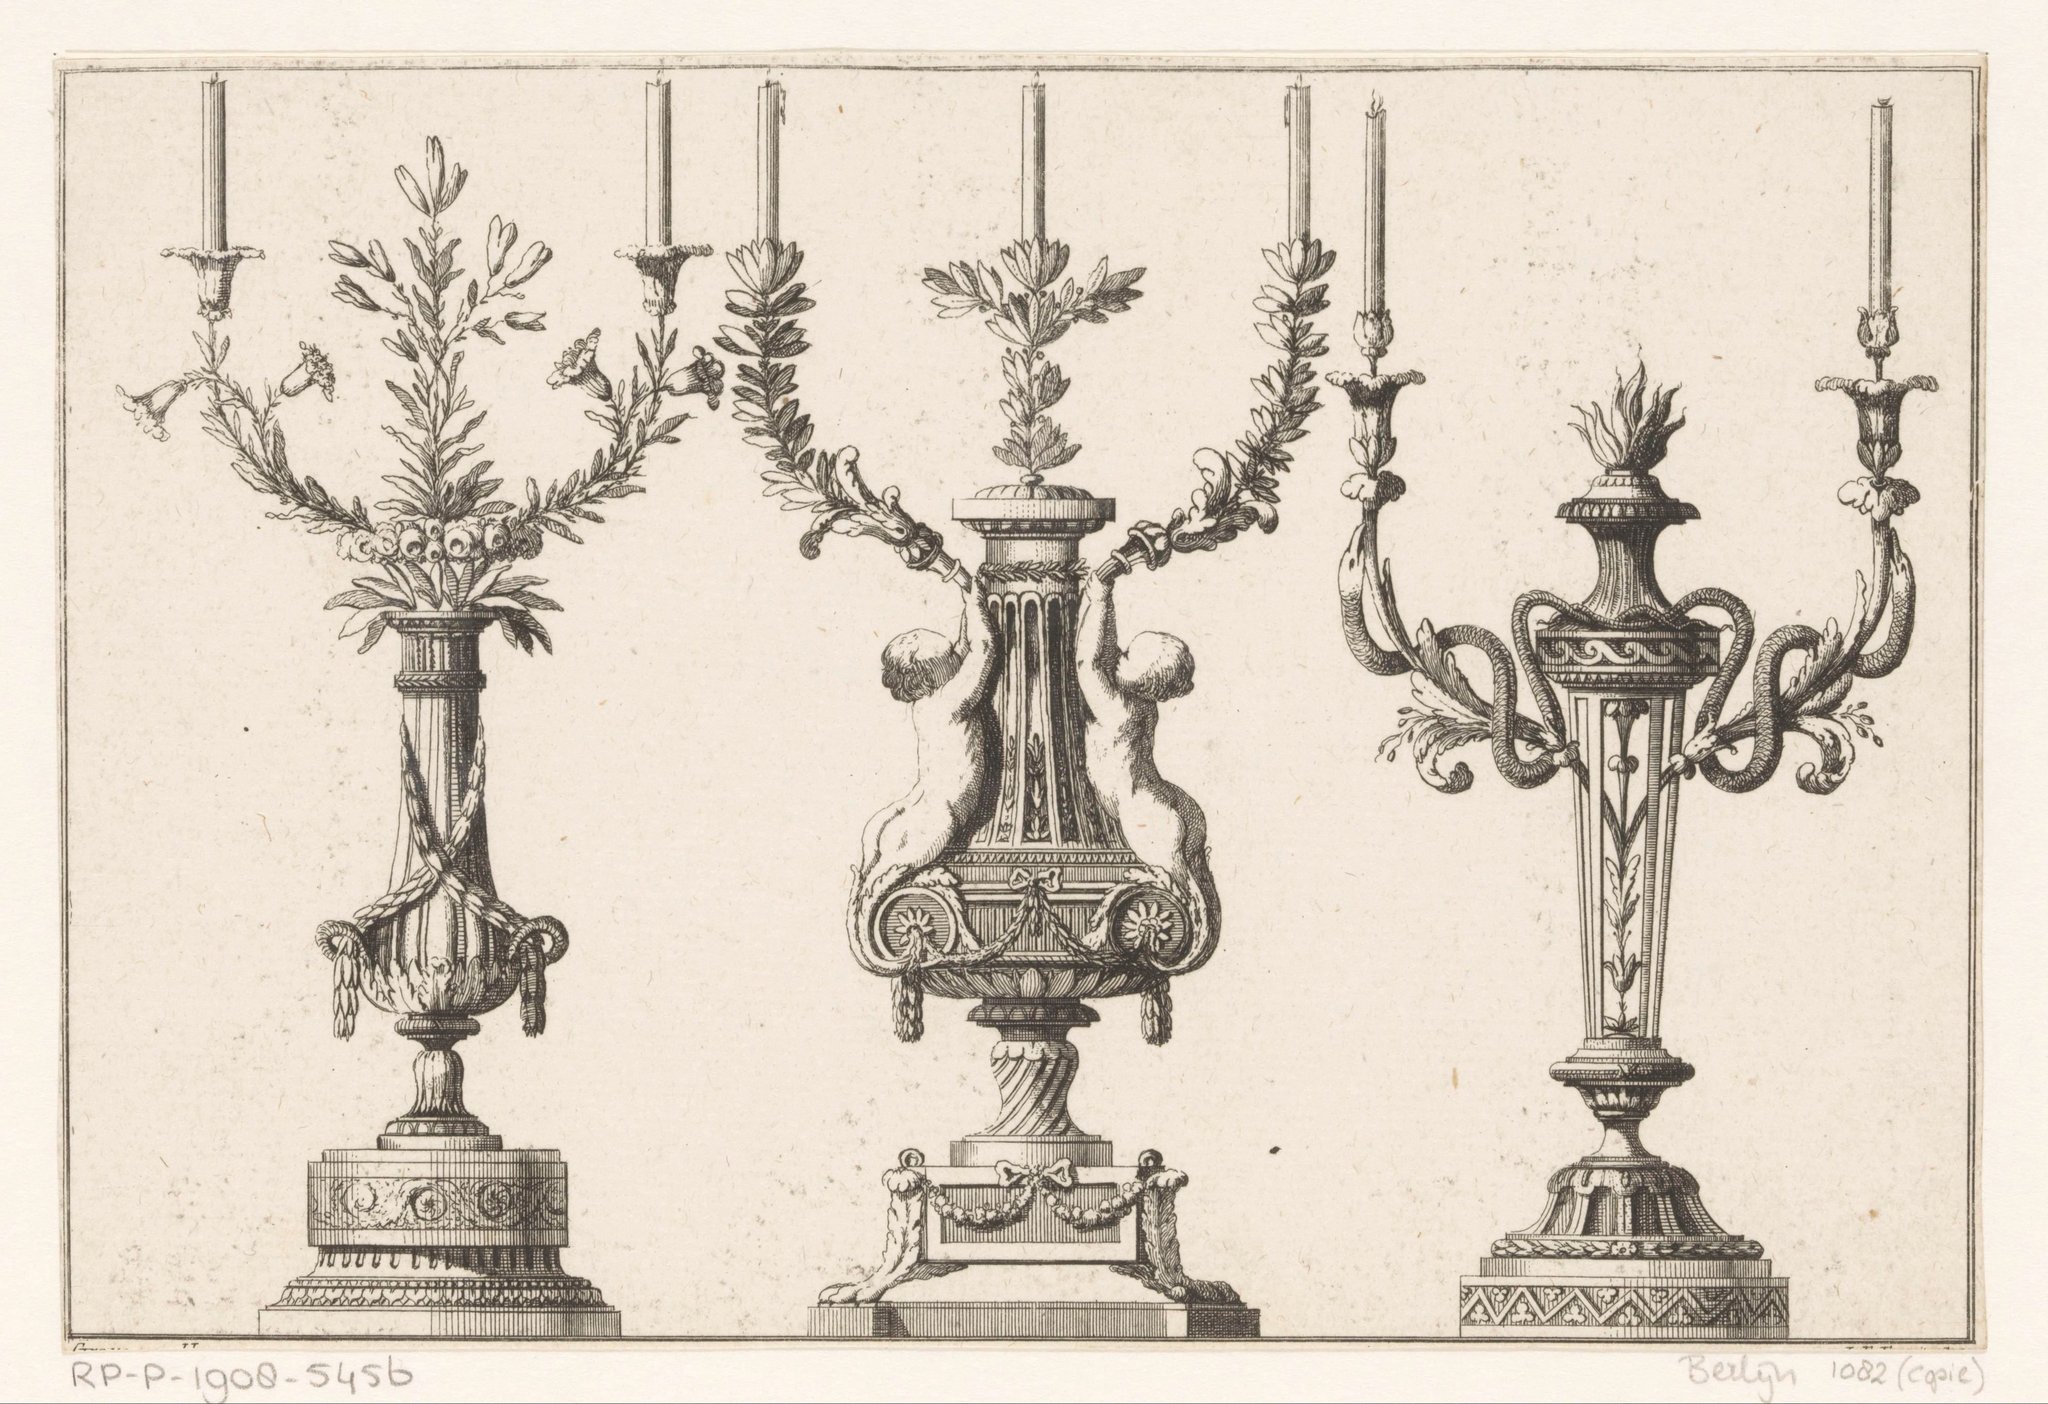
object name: ornament print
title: Kandelaars met vrouw en putti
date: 1775-1820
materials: paper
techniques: etching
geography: paris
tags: chandelier, candelabrum, standing figure - aa - female human figure, cupids: 'amores', 'amoretti', 'putti'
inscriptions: collector's mark: Lugt 2228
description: Drie geornamenteerde kandelaars, links met bokkenpoten, in het midden met een staande vrouw en rechts met twee putti op bokkenpoten.